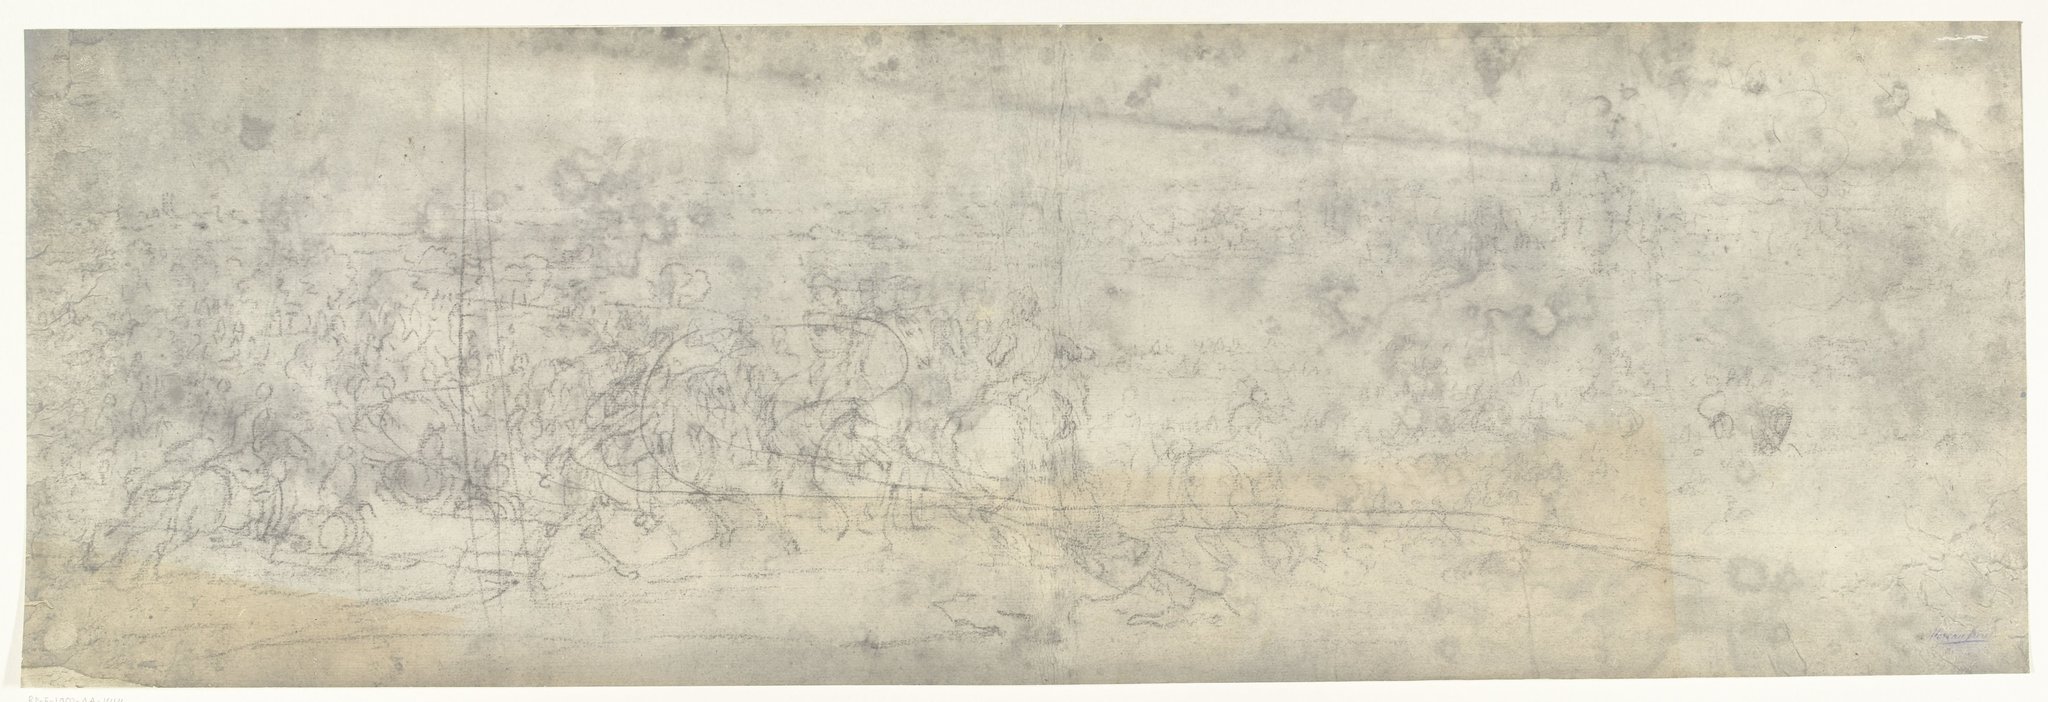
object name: photograph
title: Oversteek van de Rijn, 1672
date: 1900-1903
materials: paper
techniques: gelatin silver print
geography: france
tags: lodewijk xiv (koning van frankrijk), crossing a river, troop movements, transportation, rampjaar (disaster year)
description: Foto van een tekening van het oversteken van de Rijn bij het Tolhuis bij Lobith door het Franse leger onder Lodewijk XIV op 12 juni 1672. Onderdeel van een serie foto's van tekeningen van veroverde steden tijdens de Franse inval in de Nederlanden in 1672.